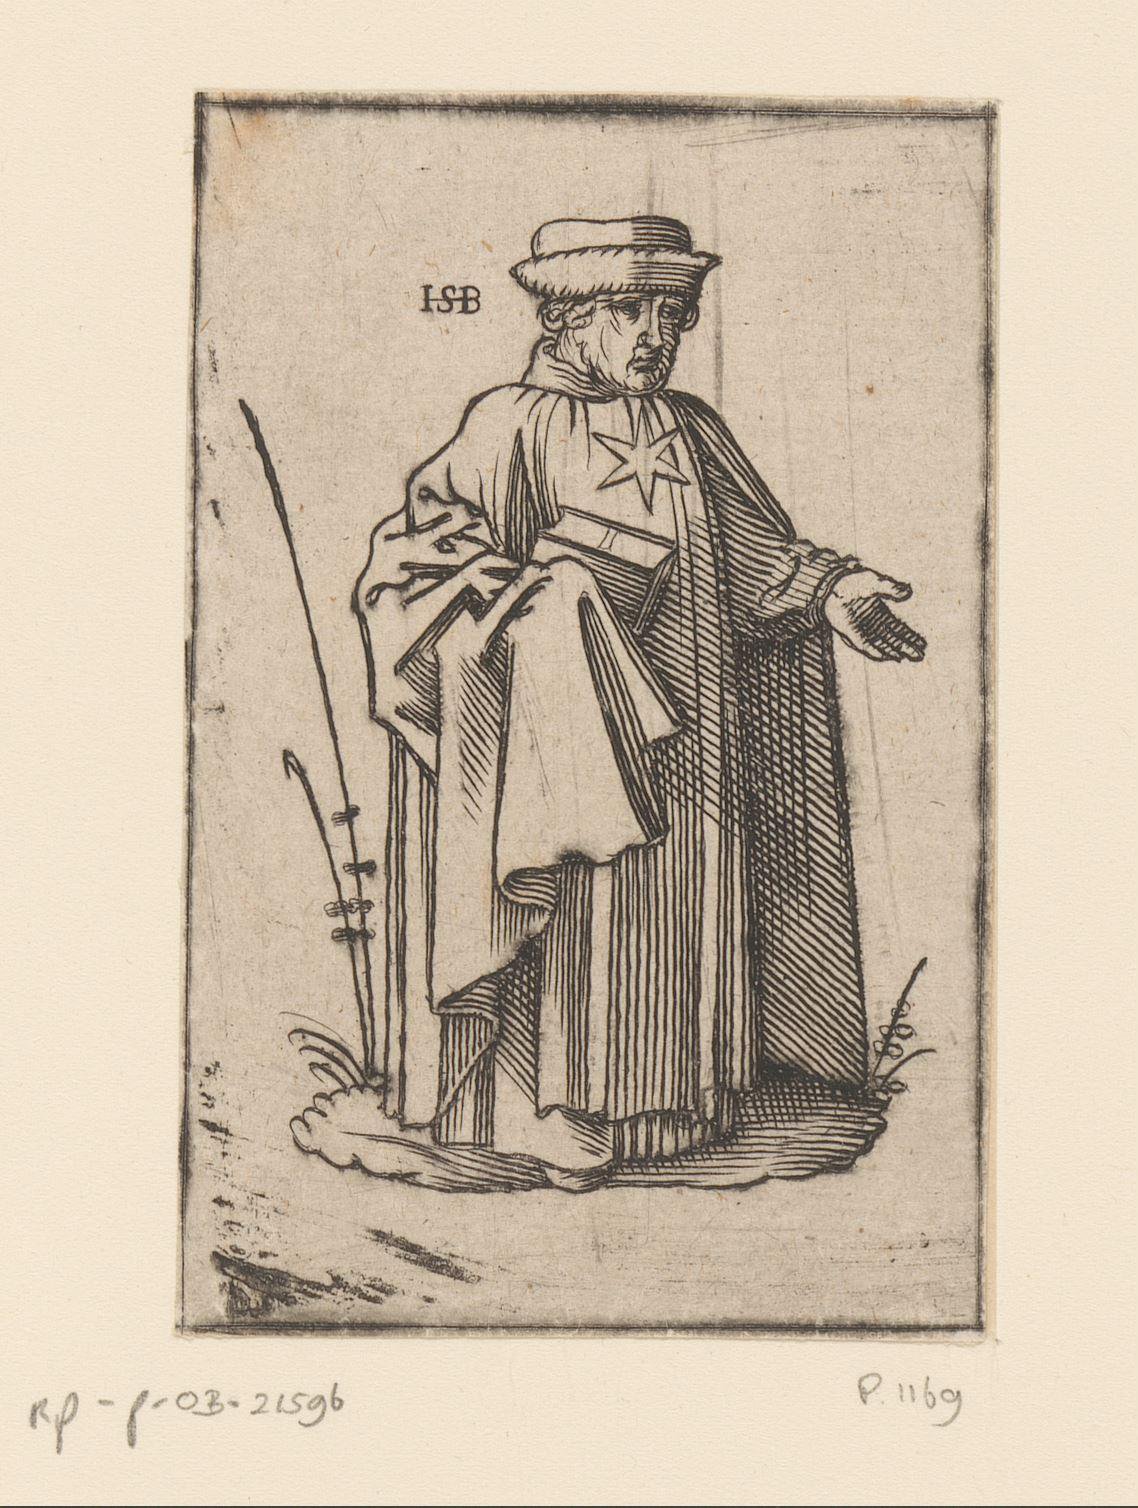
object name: print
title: Kostuums van geestelijken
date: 1526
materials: paper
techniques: engraving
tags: liturgical vestments, canonicals, monastic orders, monastic life ~ roman catholic church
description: Onderdeel van een serie van 28 gegraveerde kopieën in de andere richting naar Hans Sebald Behams "Das Papstthum mit seinen Gliedern", 1526.